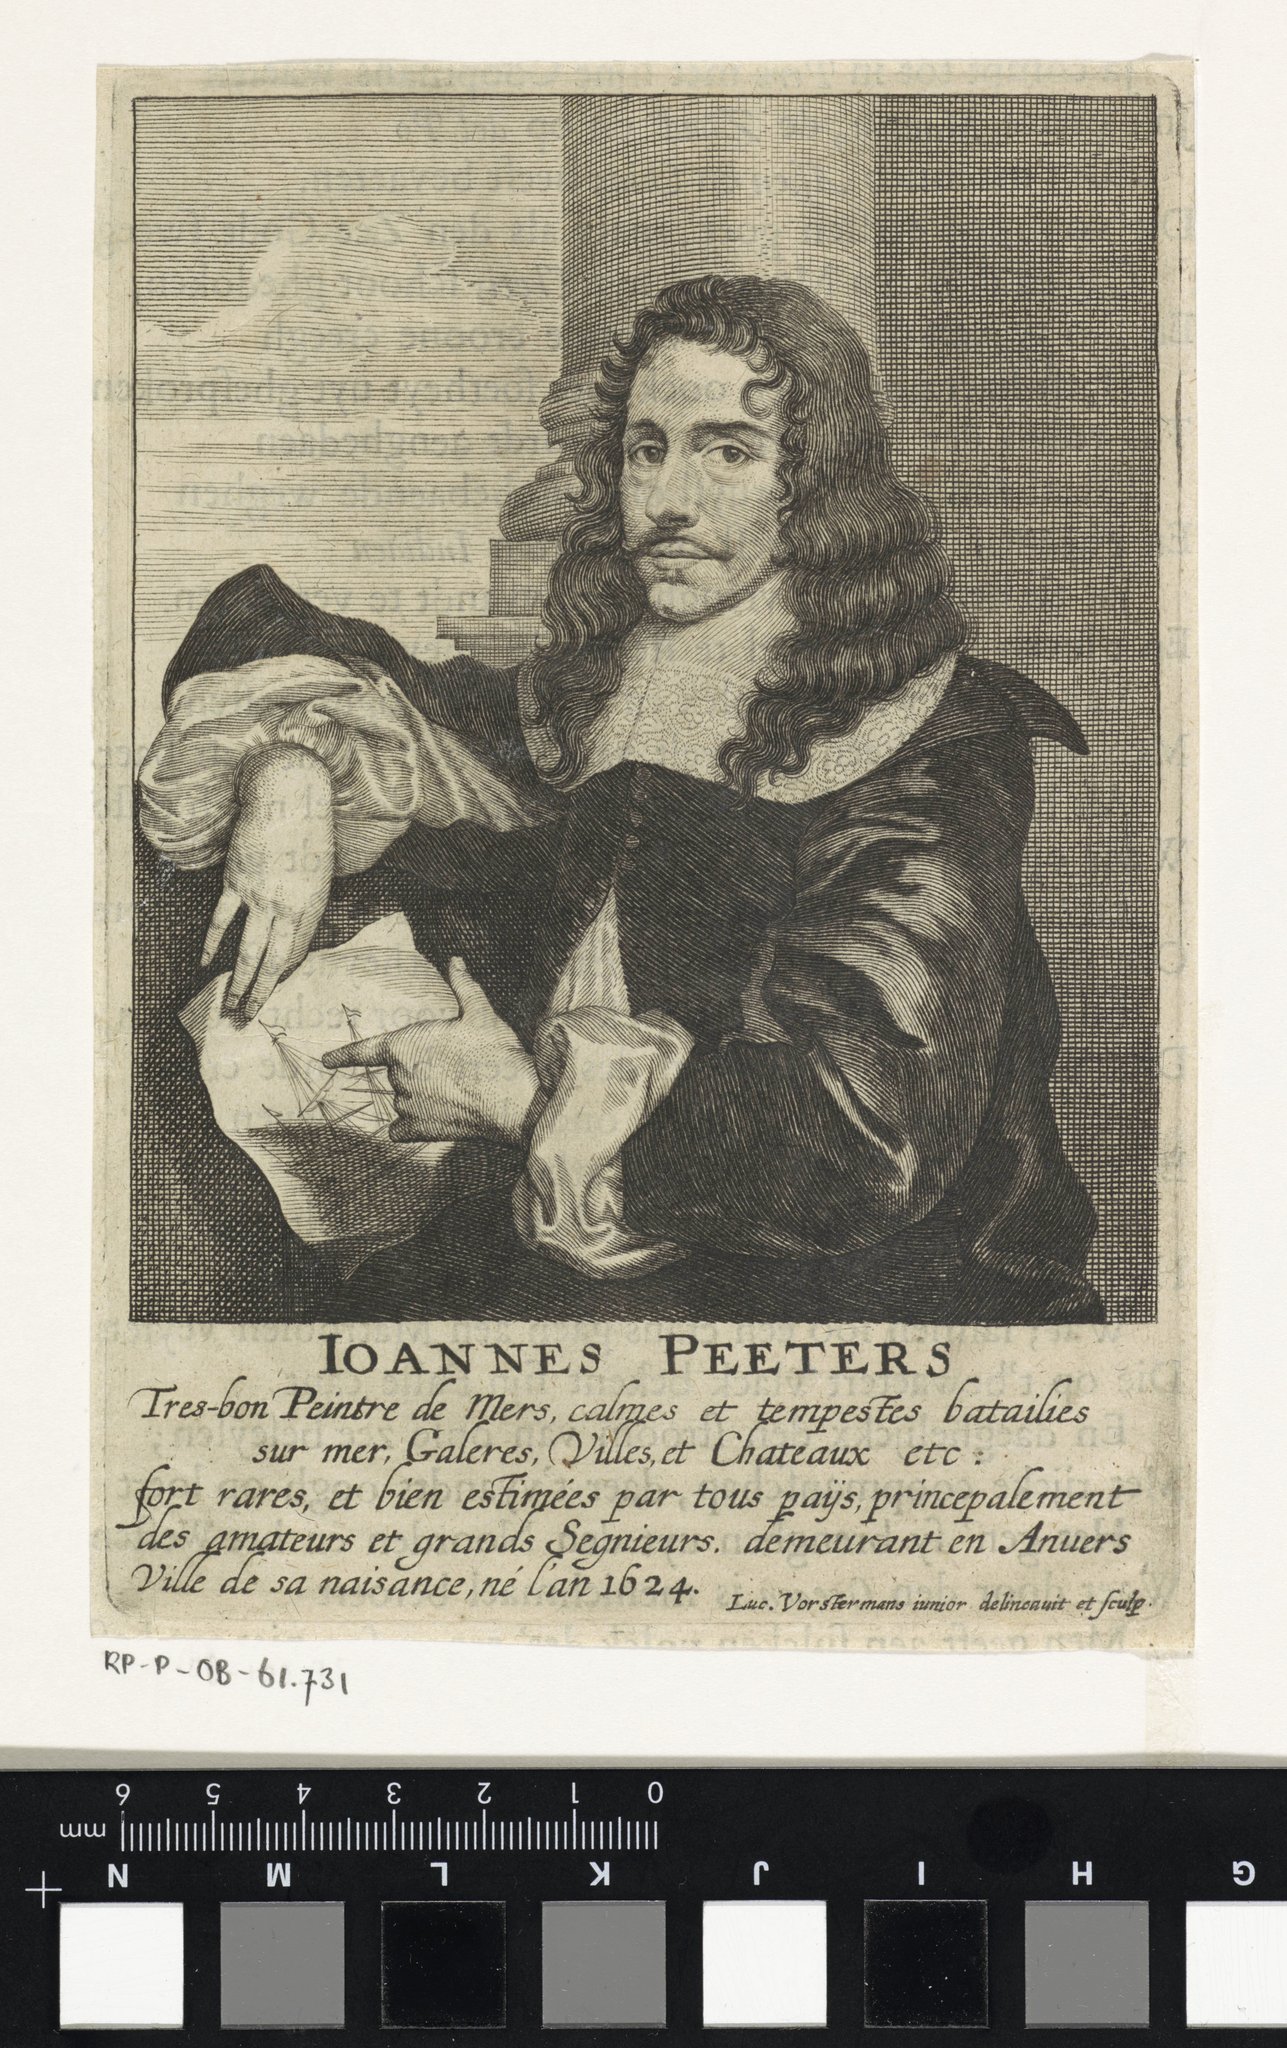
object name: print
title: Portret van Jan Peeters I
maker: lucas vorsterman (ii)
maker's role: print maker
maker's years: 1624-1667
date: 1662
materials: paper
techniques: engraving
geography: antwerp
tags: antwerp, draughtsman, jan peeters (i), historical persons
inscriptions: collector's mark: Lugt 2228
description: Prent gebruikt in: Bie, Cornelis de. Het gulden cabinet vande edele vry schilder-const. : 3 delen. Antwerpen, Joannes Meyssens, 1662.